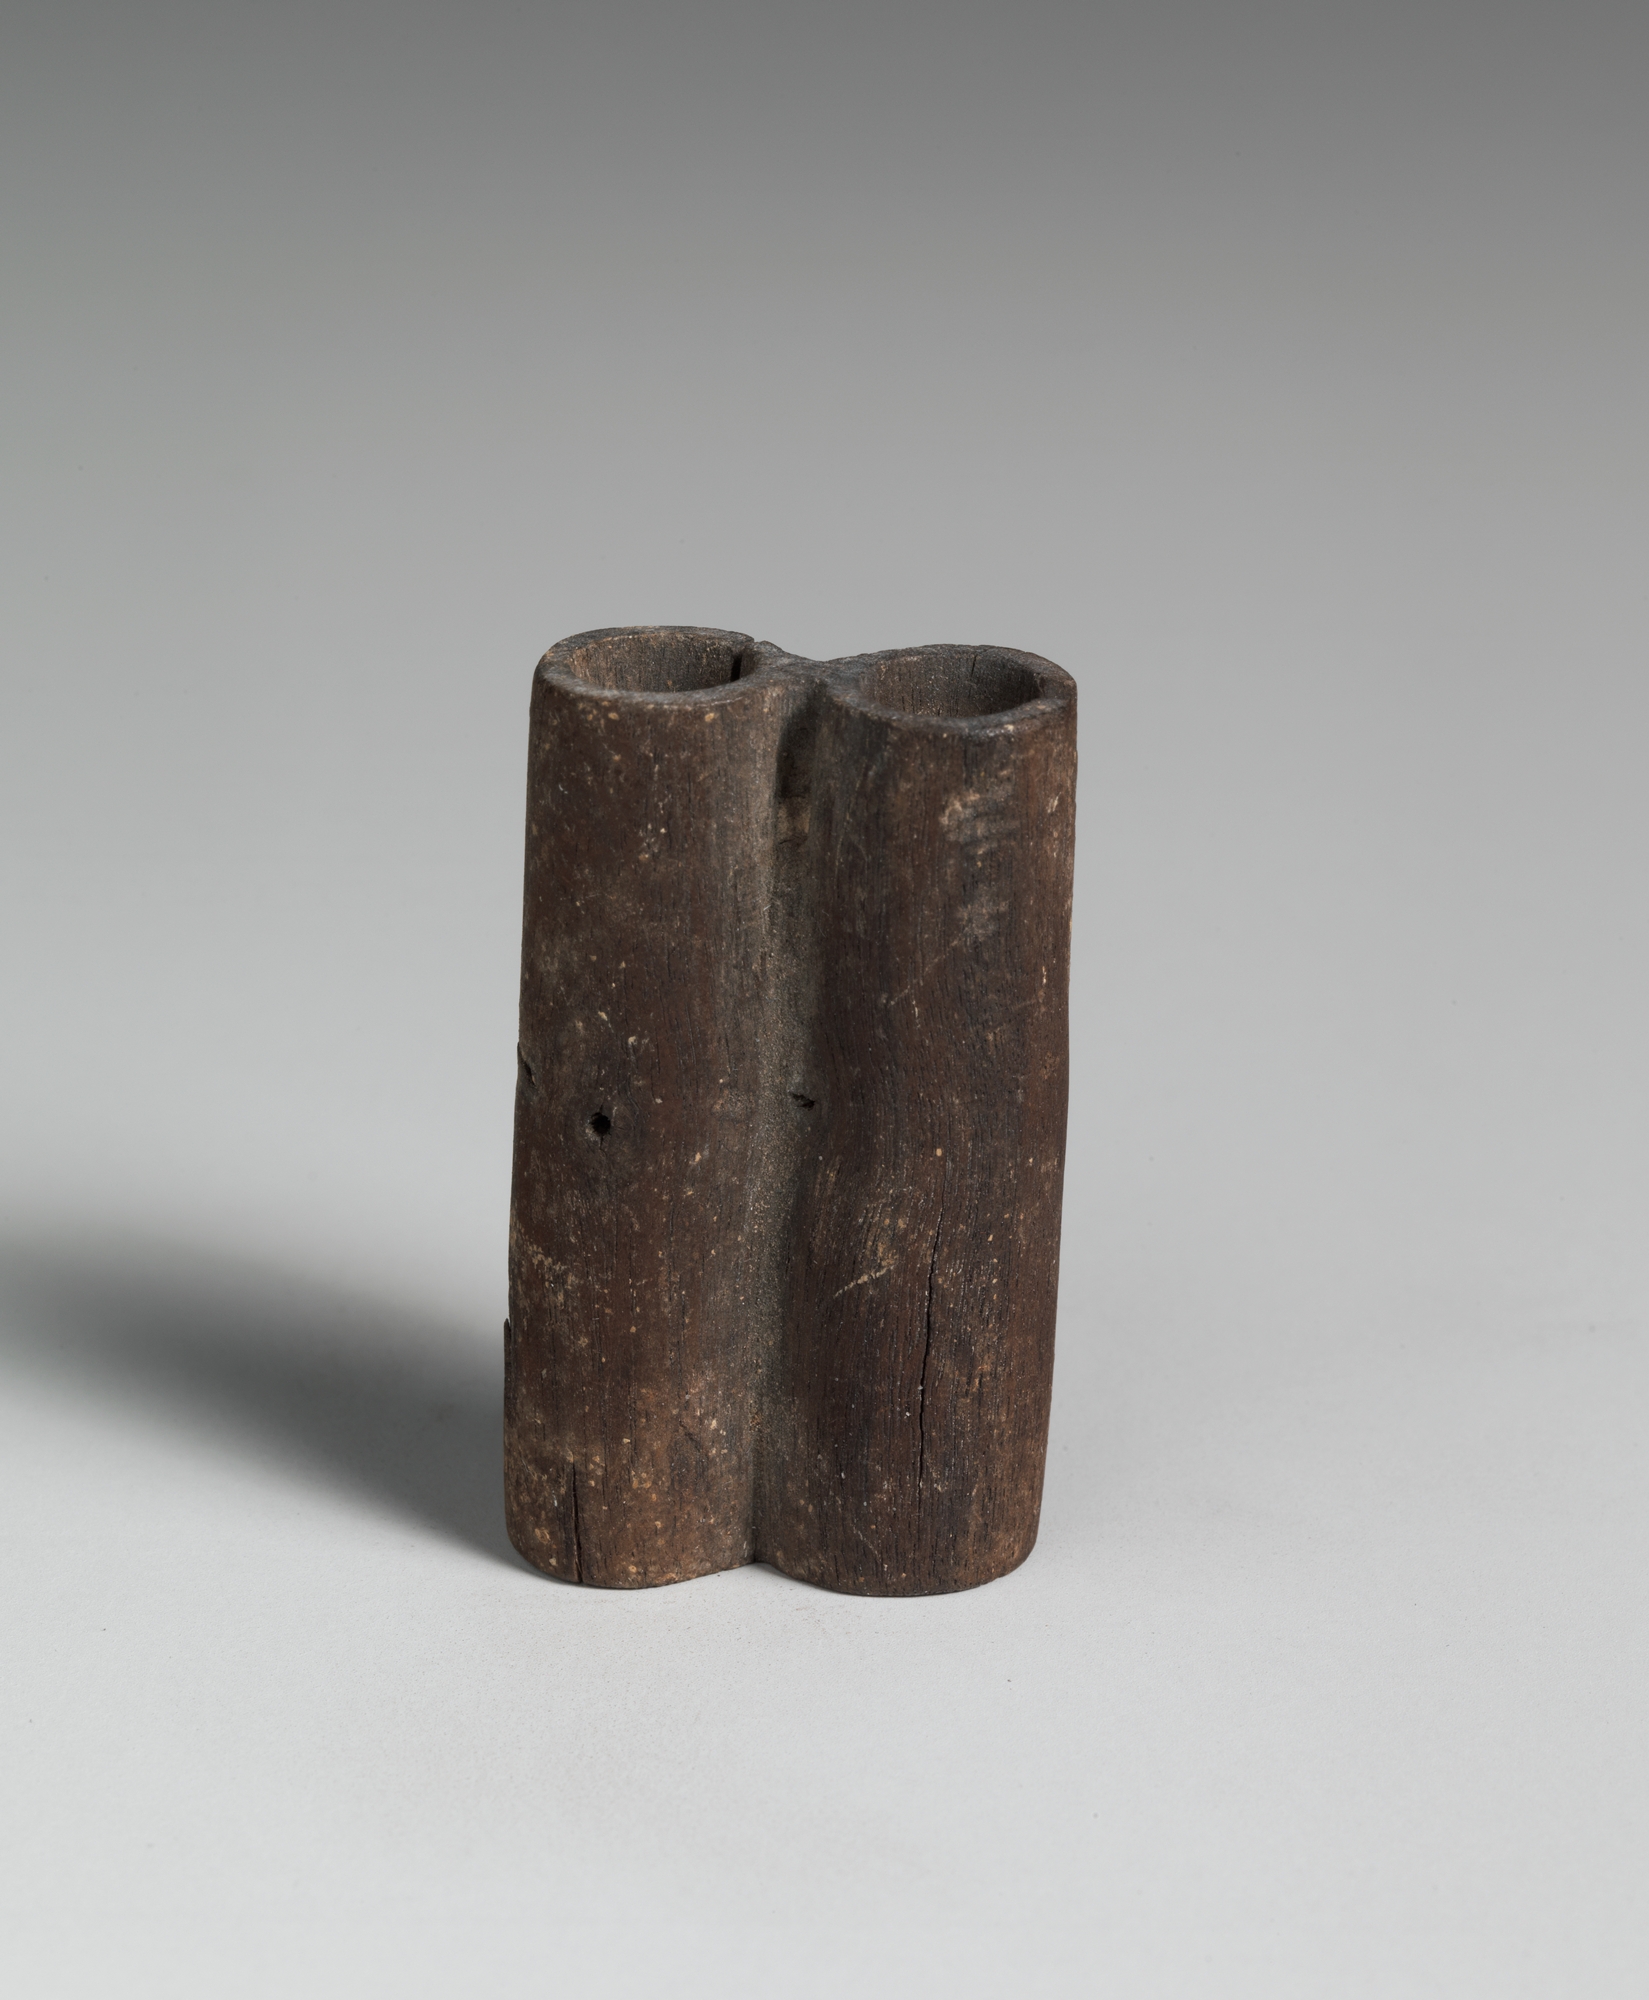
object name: kohl tube, double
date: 1550-1458 BCE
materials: bronze, copper alloy, wood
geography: egypt